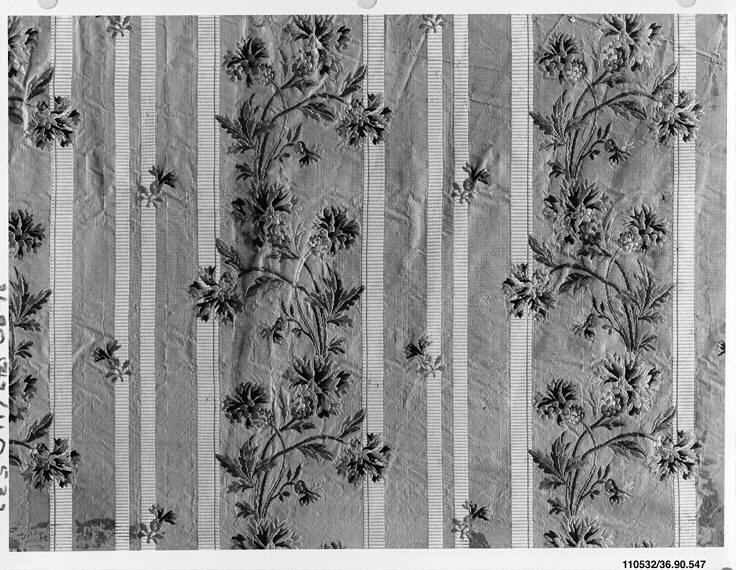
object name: piece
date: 1767-1800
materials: silk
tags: flowers,leaves